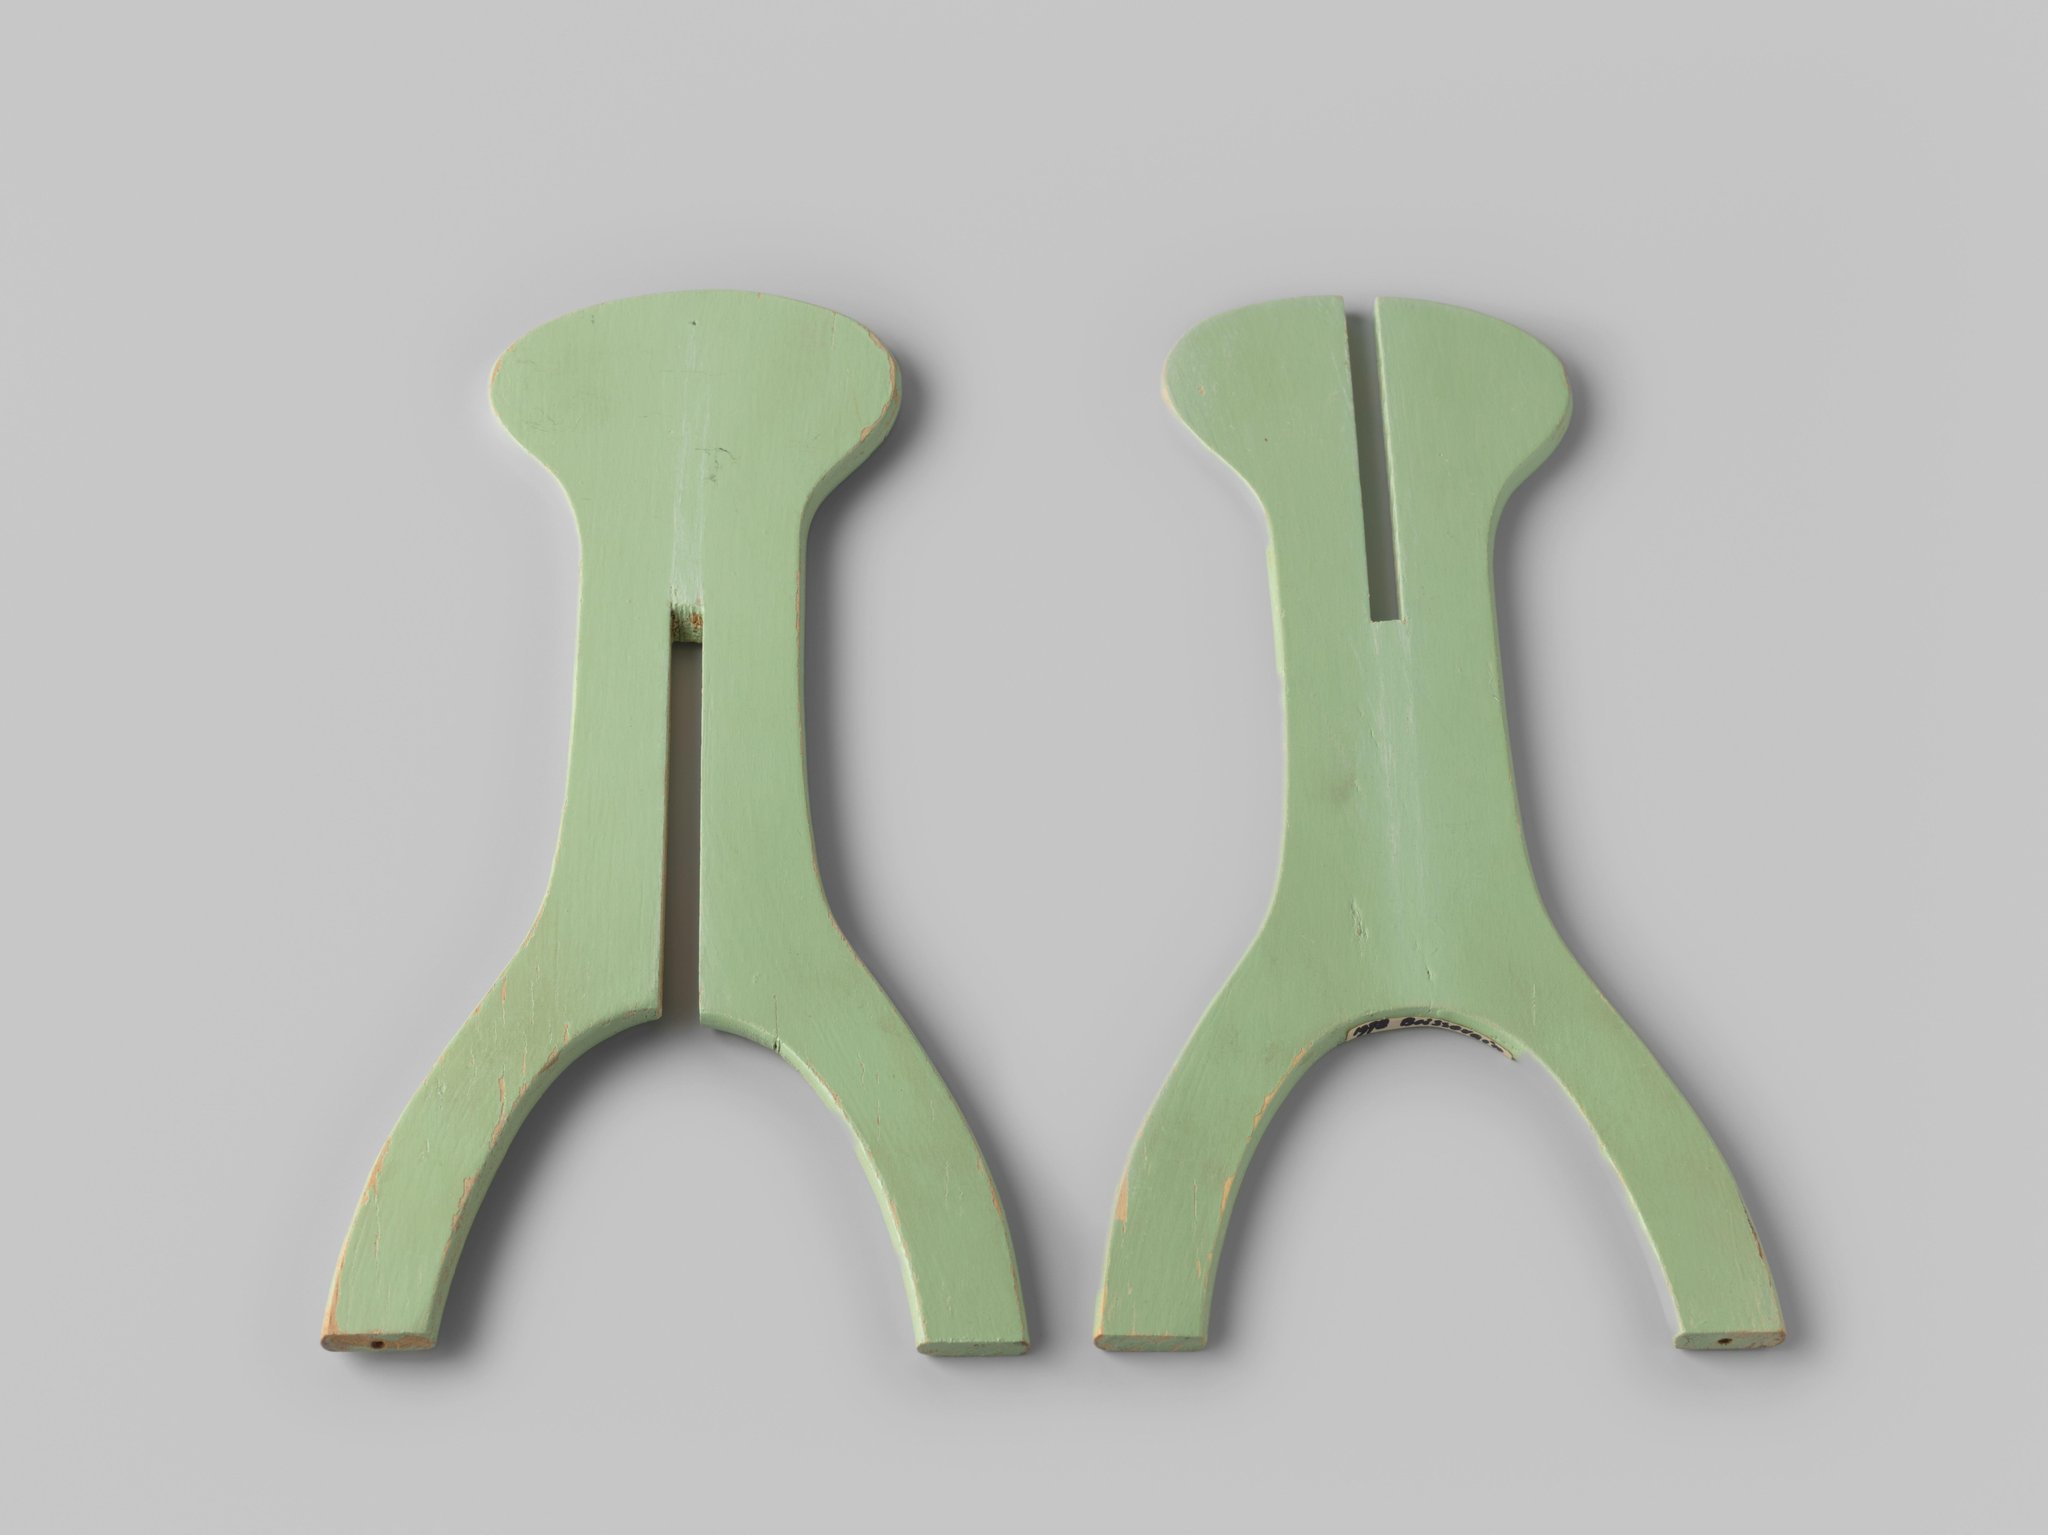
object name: hat stand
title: Hoedenstandaard, samengesteld uit twee in elkaar passende lichtgroene planken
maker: Anonymous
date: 1950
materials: wood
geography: western europe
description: Hoedenstandaard, samengesteld uit twee in elkaar passende lichtgroene planken.